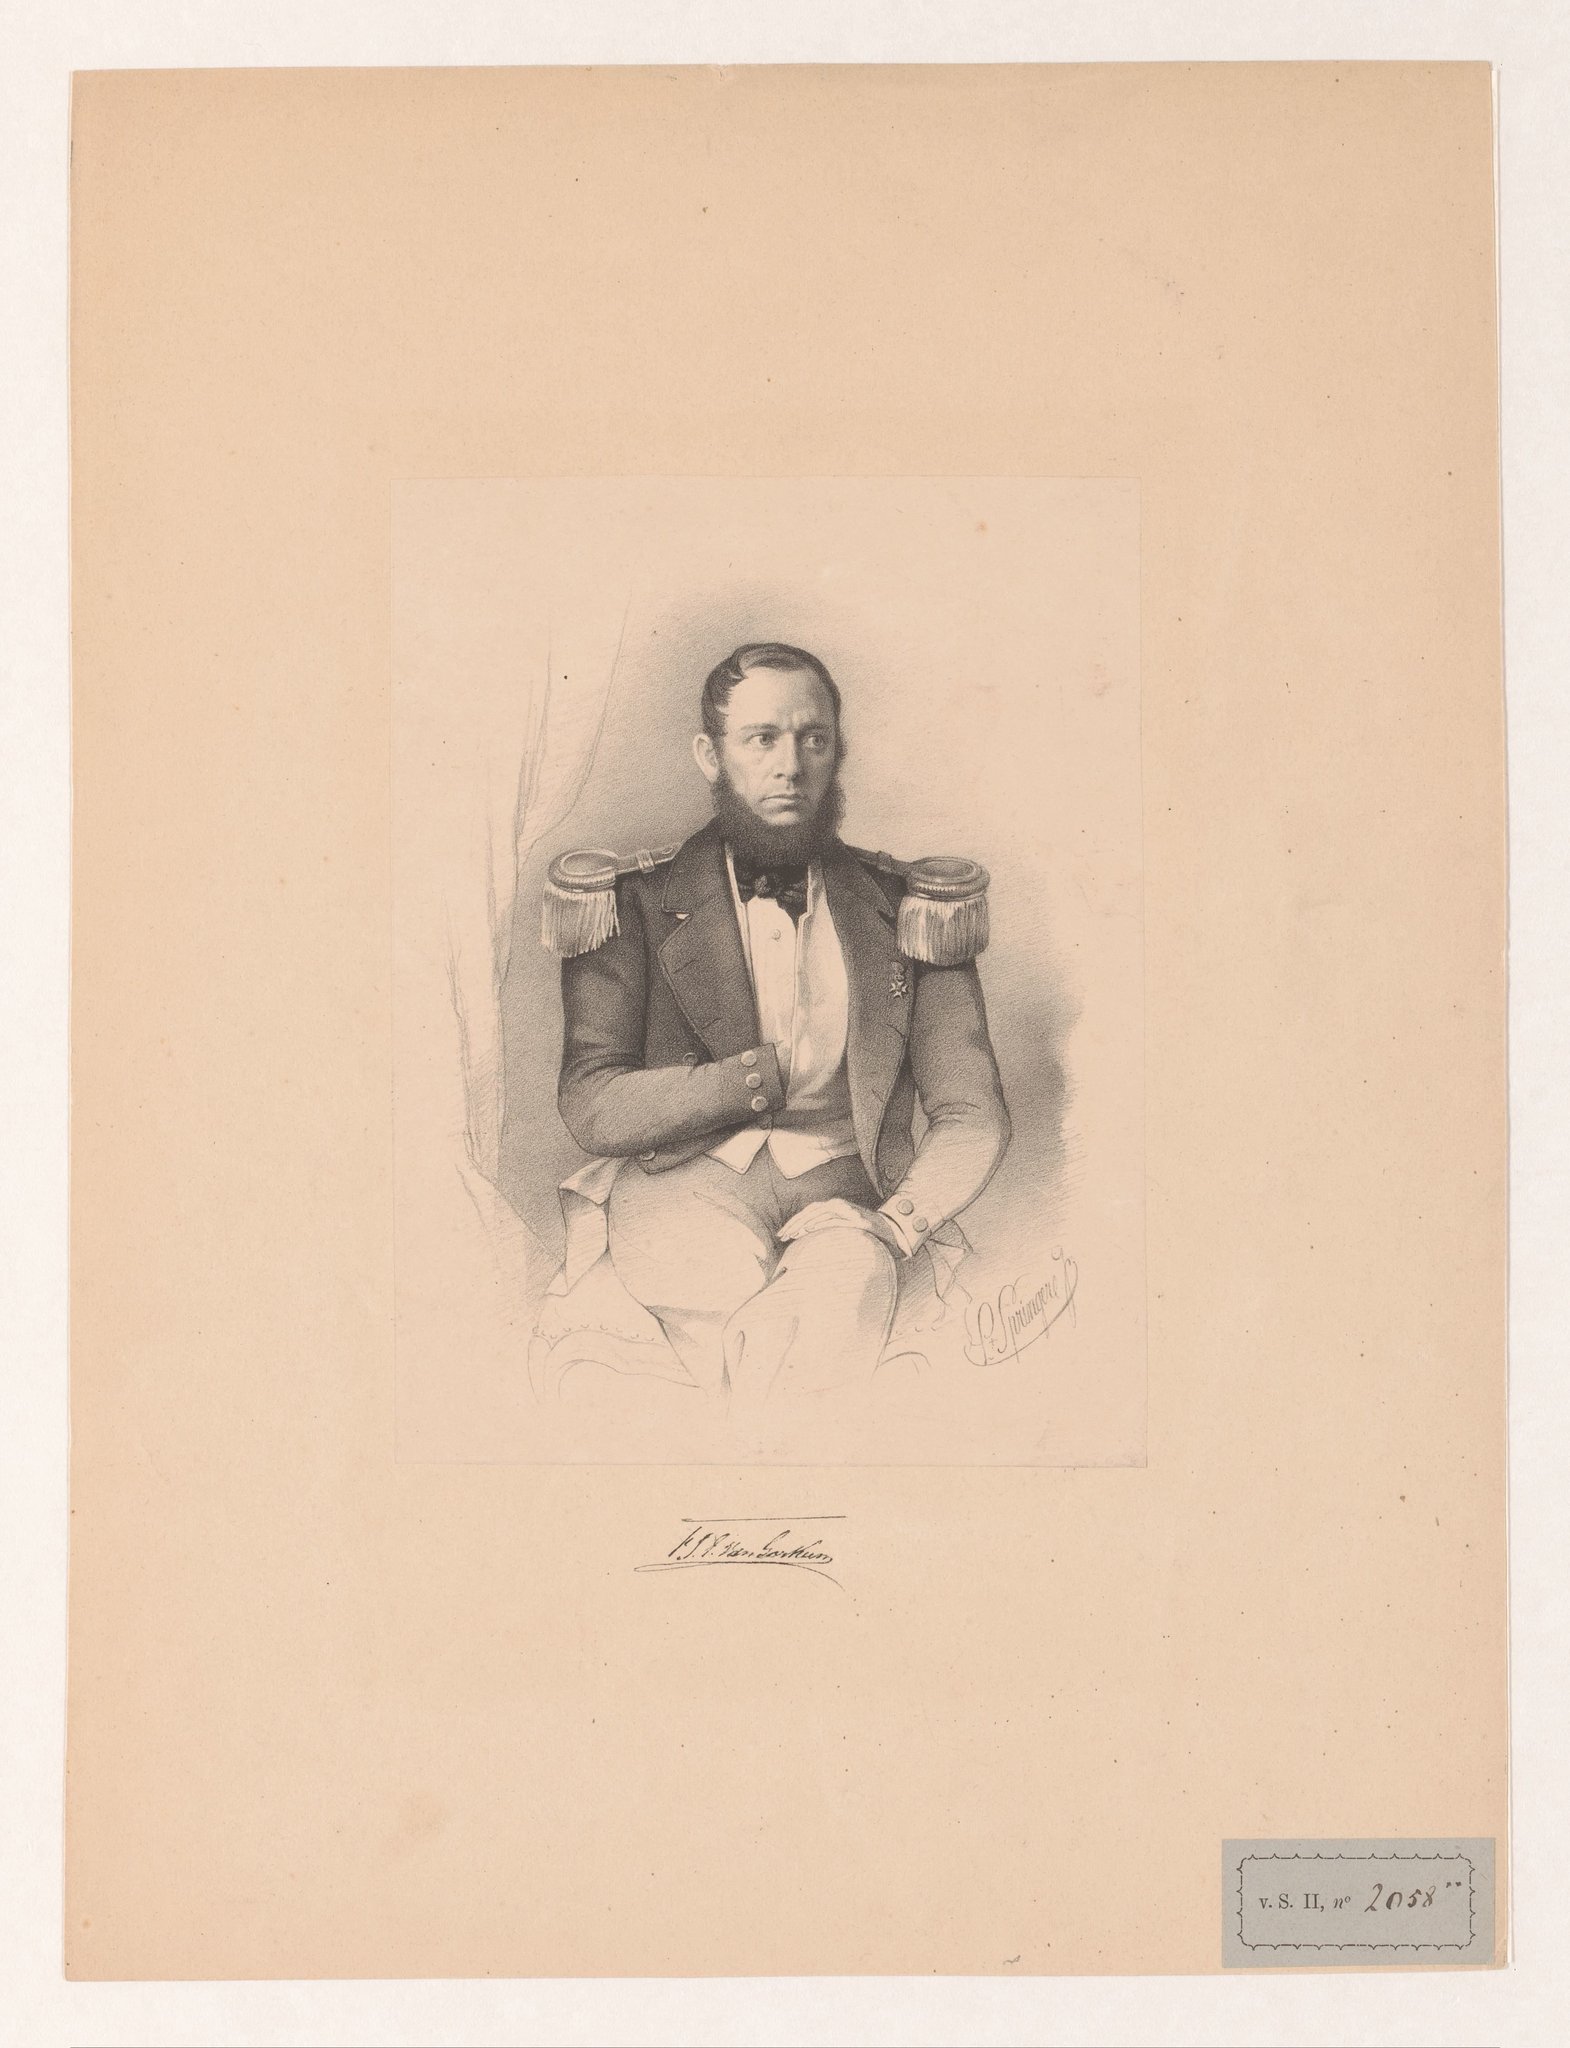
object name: print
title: Portret van F.J.E. van Gorkum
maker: leendert springer (ii)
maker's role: draughtsman, print maker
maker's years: 1831-1894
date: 1841-1894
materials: paper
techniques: lithograph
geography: netherlands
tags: historical persons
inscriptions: collector's mark: Lugt 2228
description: Onder het portret de signatuur van de geportretteerde.